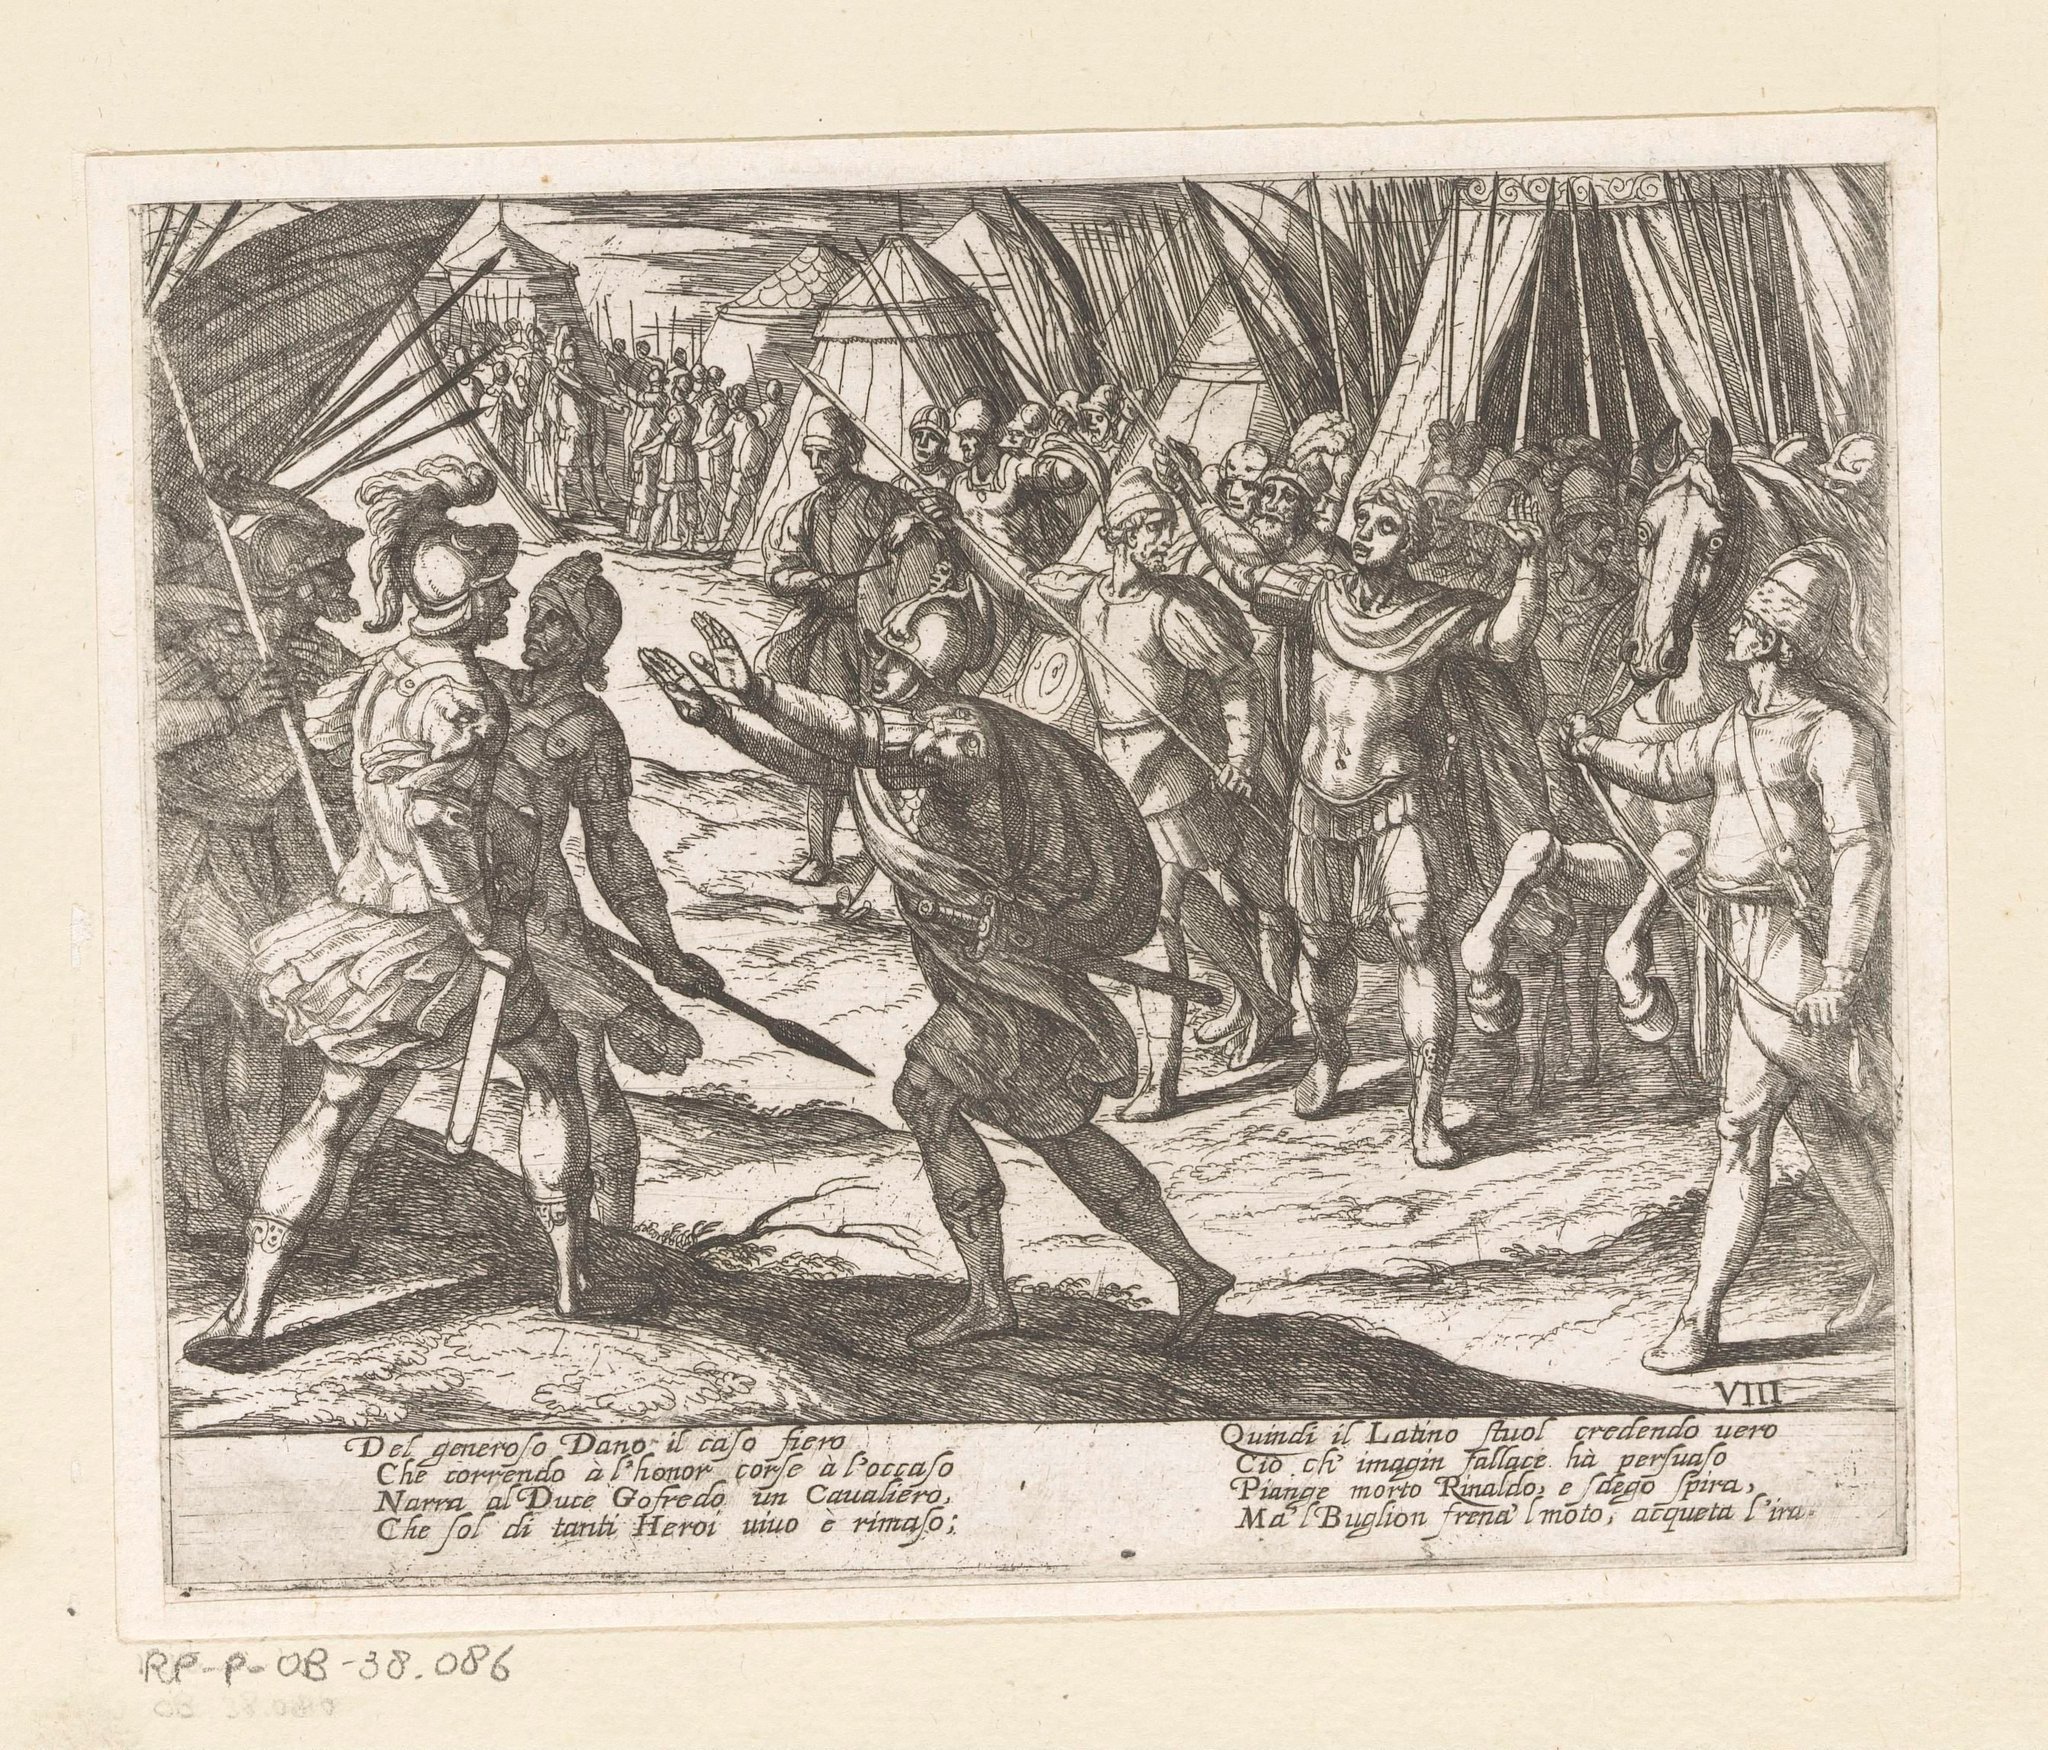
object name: print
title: Gerusalemme Liberata (deel 2)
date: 1565-1630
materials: paper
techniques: etching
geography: italy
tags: militant proselytizing: religious war, crusade, etc., (scenes from) specific works of literature: tasso, gerusalemme liberata, knight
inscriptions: collector's mark: Lugt 240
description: Deze prent maakt deel uit van een reeks van twintig prenten (+ opdracht) met voorstellingen van scènes uit Tasso's 'Jeruzalem verlost', een episch gedicht geschreven door de Italiaanse dichter Torquato Tasso en voor het eerst gepubliceerd in 1581. Het verhaal vertelt grotendeels in fictie over de Eerste Kruistocht waarin de christenen, geleid door Godfried van Bouillon, de strijd aangaan met de moslims om het Beleg van Jeruzalem.